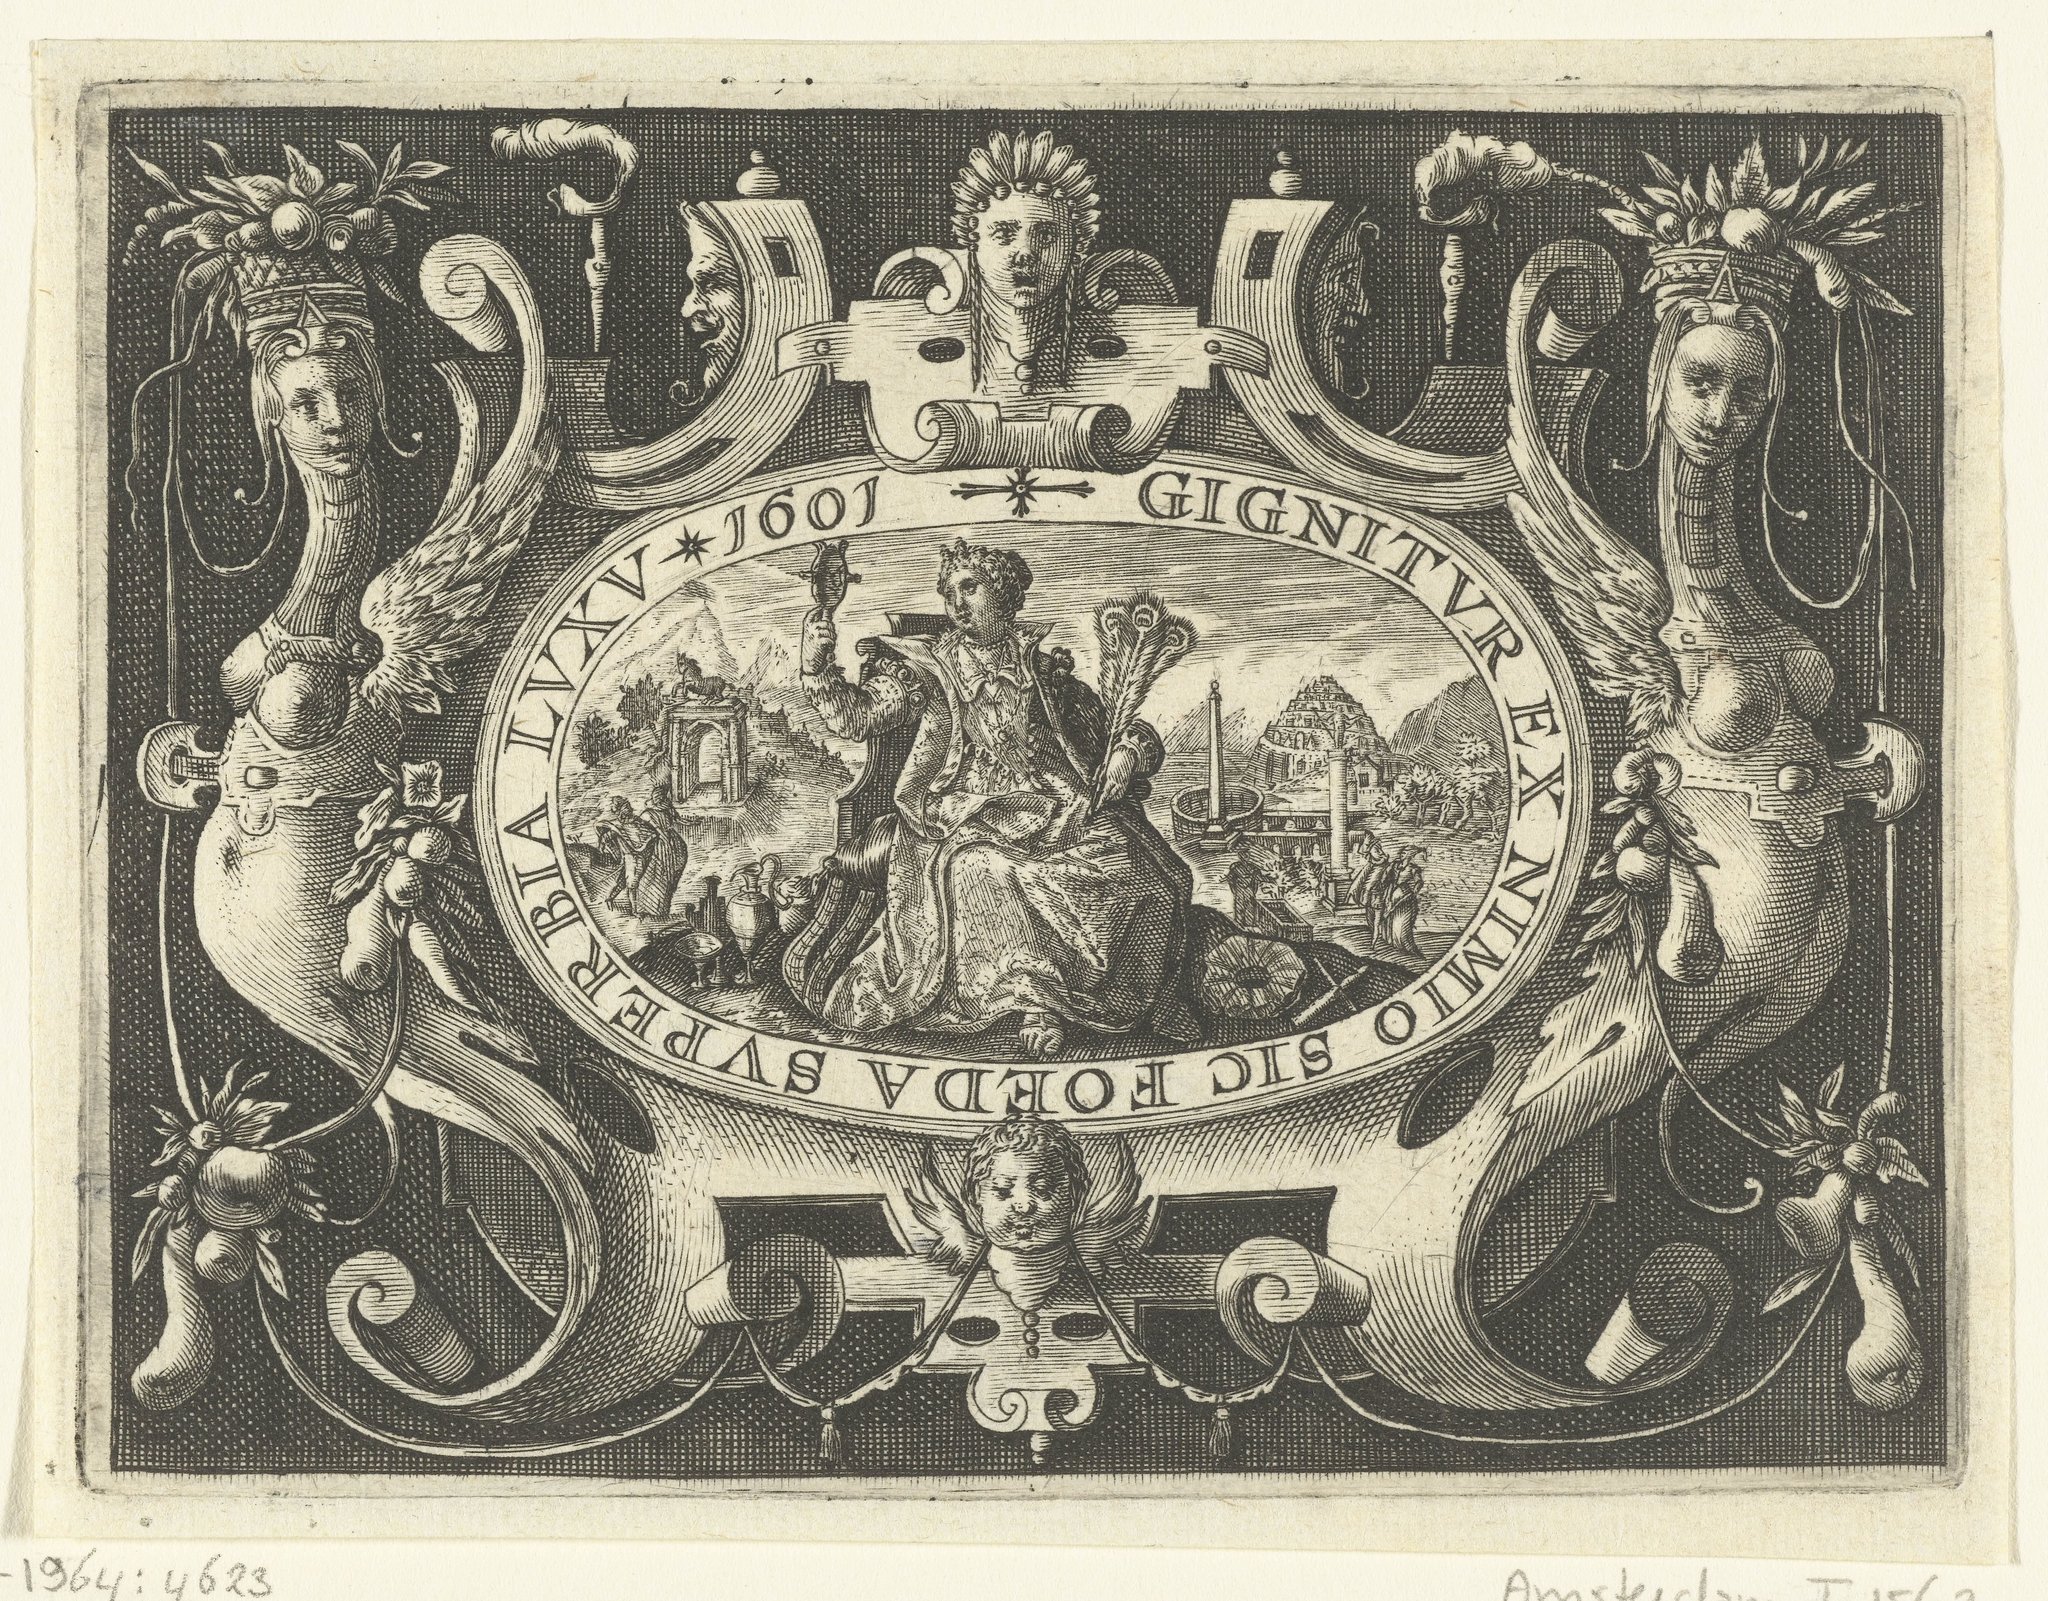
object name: ornament print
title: GIGNITVR EX NIMIO SIC FOEDA SVPERBIA LVXV 1601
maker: Anonymous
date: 1601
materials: paper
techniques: engraving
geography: netherlands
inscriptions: collector's mark: Lugt 2542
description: De cartouche wordt geflankeerd door twee sirene-achtige figuren met manden op hun hoofd. Blad afkomstig uit serie van 8 bladen met cartouches in een omlijsting van rolwerk met grotesken, guirlandes en mascarons.